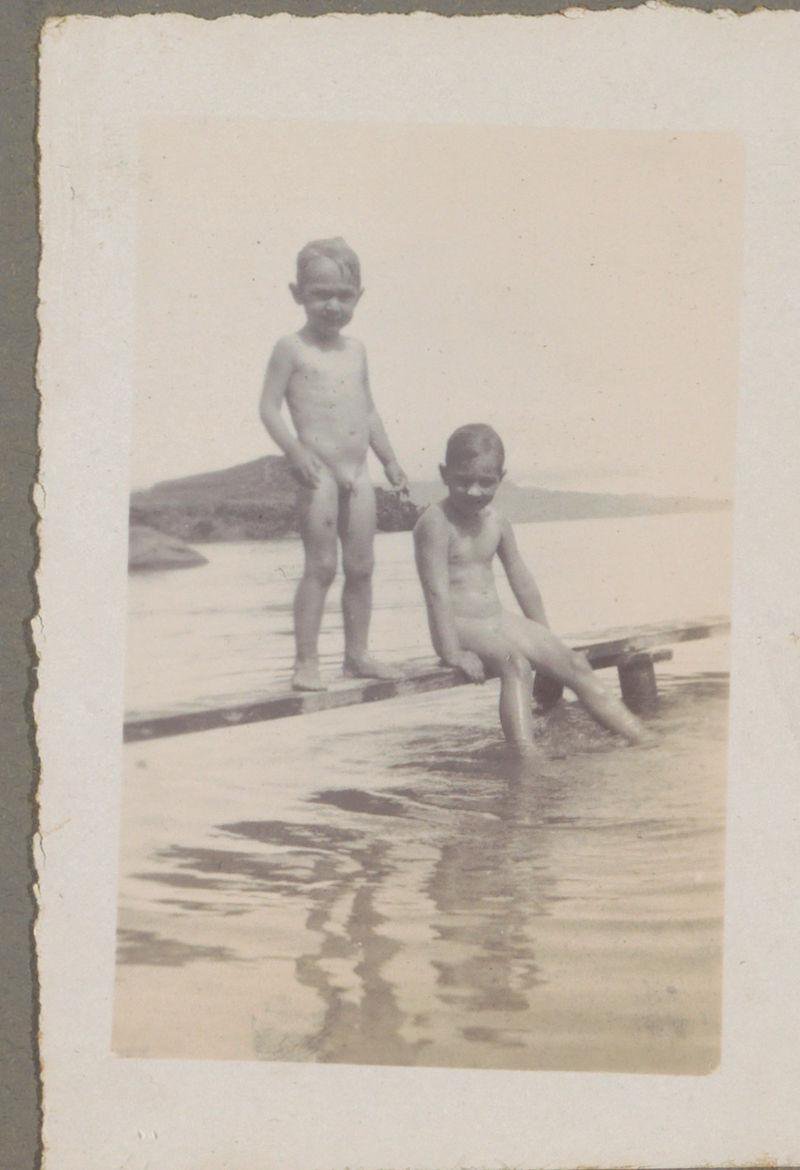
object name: photograph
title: Georges en Hans Bergsma bij een water op Sumatra, naakt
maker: Anonymous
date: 1914-1926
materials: photographic support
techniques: gelatin silver print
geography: sumatra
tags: utrecht, child, swimming (movement in water), sumatra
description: Onderdeel van fotoalbum met opnames van de familie Bergsma in Tandjong Poera en Rantan Pandjang (Sumatra).